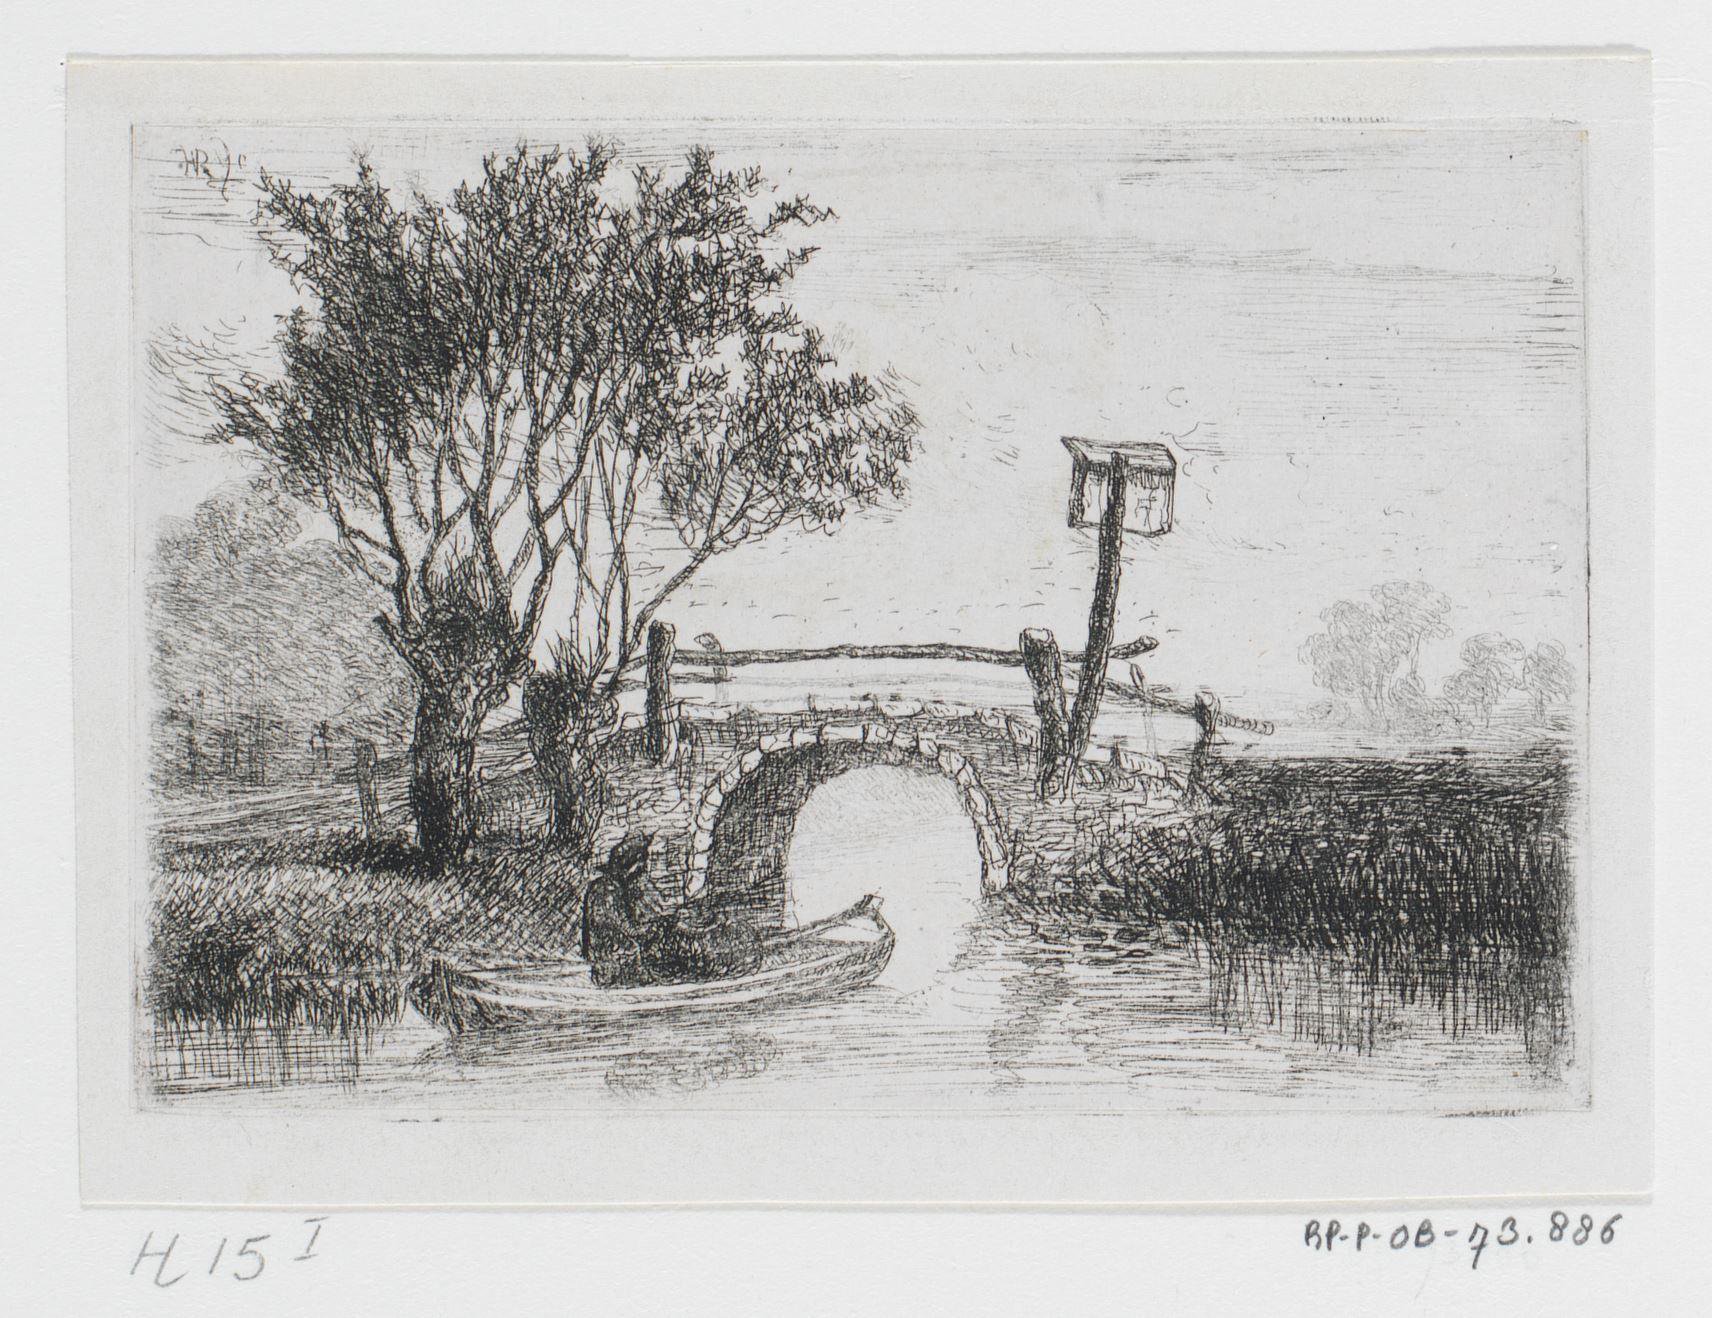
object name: print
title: Stenen brug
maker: hermanus jan hendrik van rijkelijkhuysen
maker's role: painter, print maker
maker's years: 1813-1883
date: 1823-1883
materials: paper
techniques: drypoint, etching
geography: utrecht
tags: rowing-boat, canoe, etc., brook, trees: willow, bridge, fisherman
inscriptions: collector's mark: Lugt 2228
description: Gezicht op een vlak landschap met een stenen brug waar een visser in een bootje voor ligt. Naast de brug twee knotwilgen en een bord.